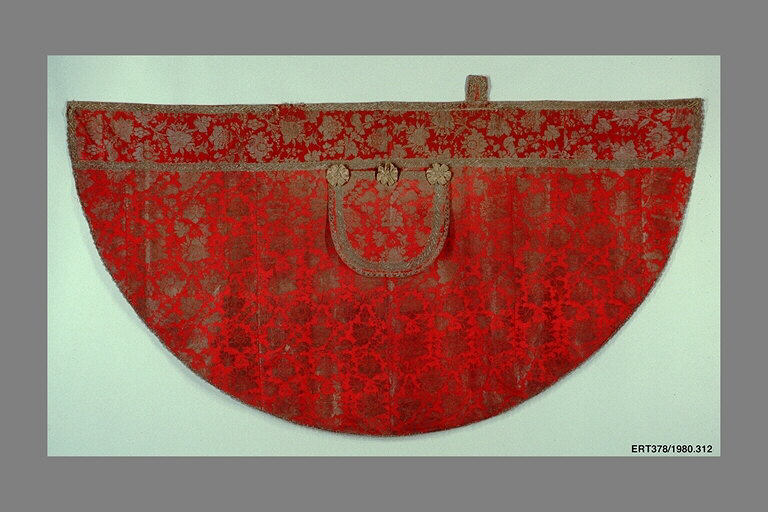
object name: cope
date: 1701-1800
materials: metal thread, silk